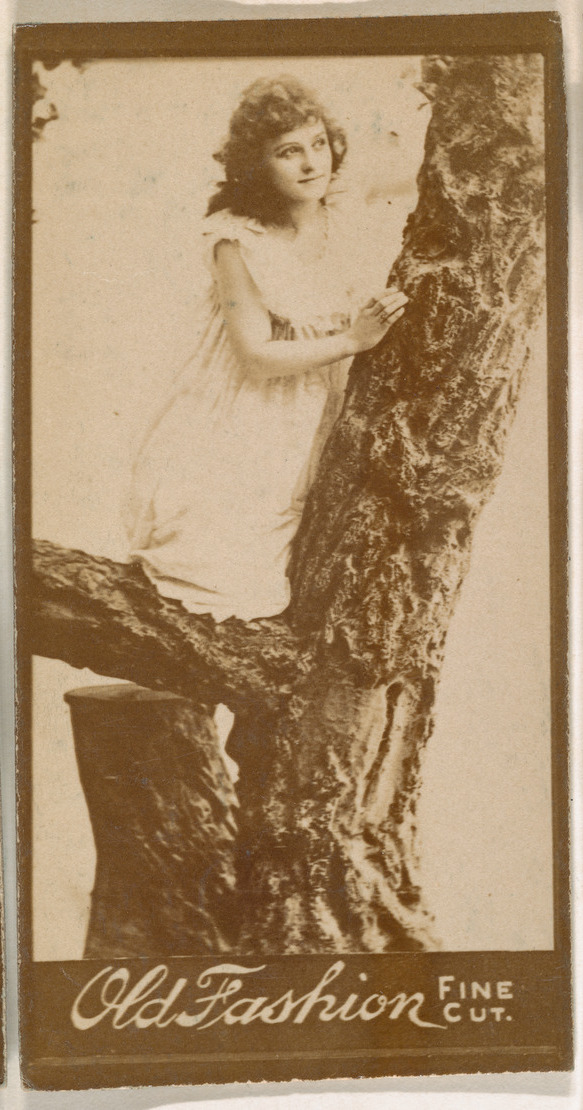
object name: photograph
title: Actress climbing tree, from the Actresses series (N664) promoting Old Fashion Fine Cut Tobacco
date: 1888-1890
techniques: albumen silver print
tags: portraits,women,actresses